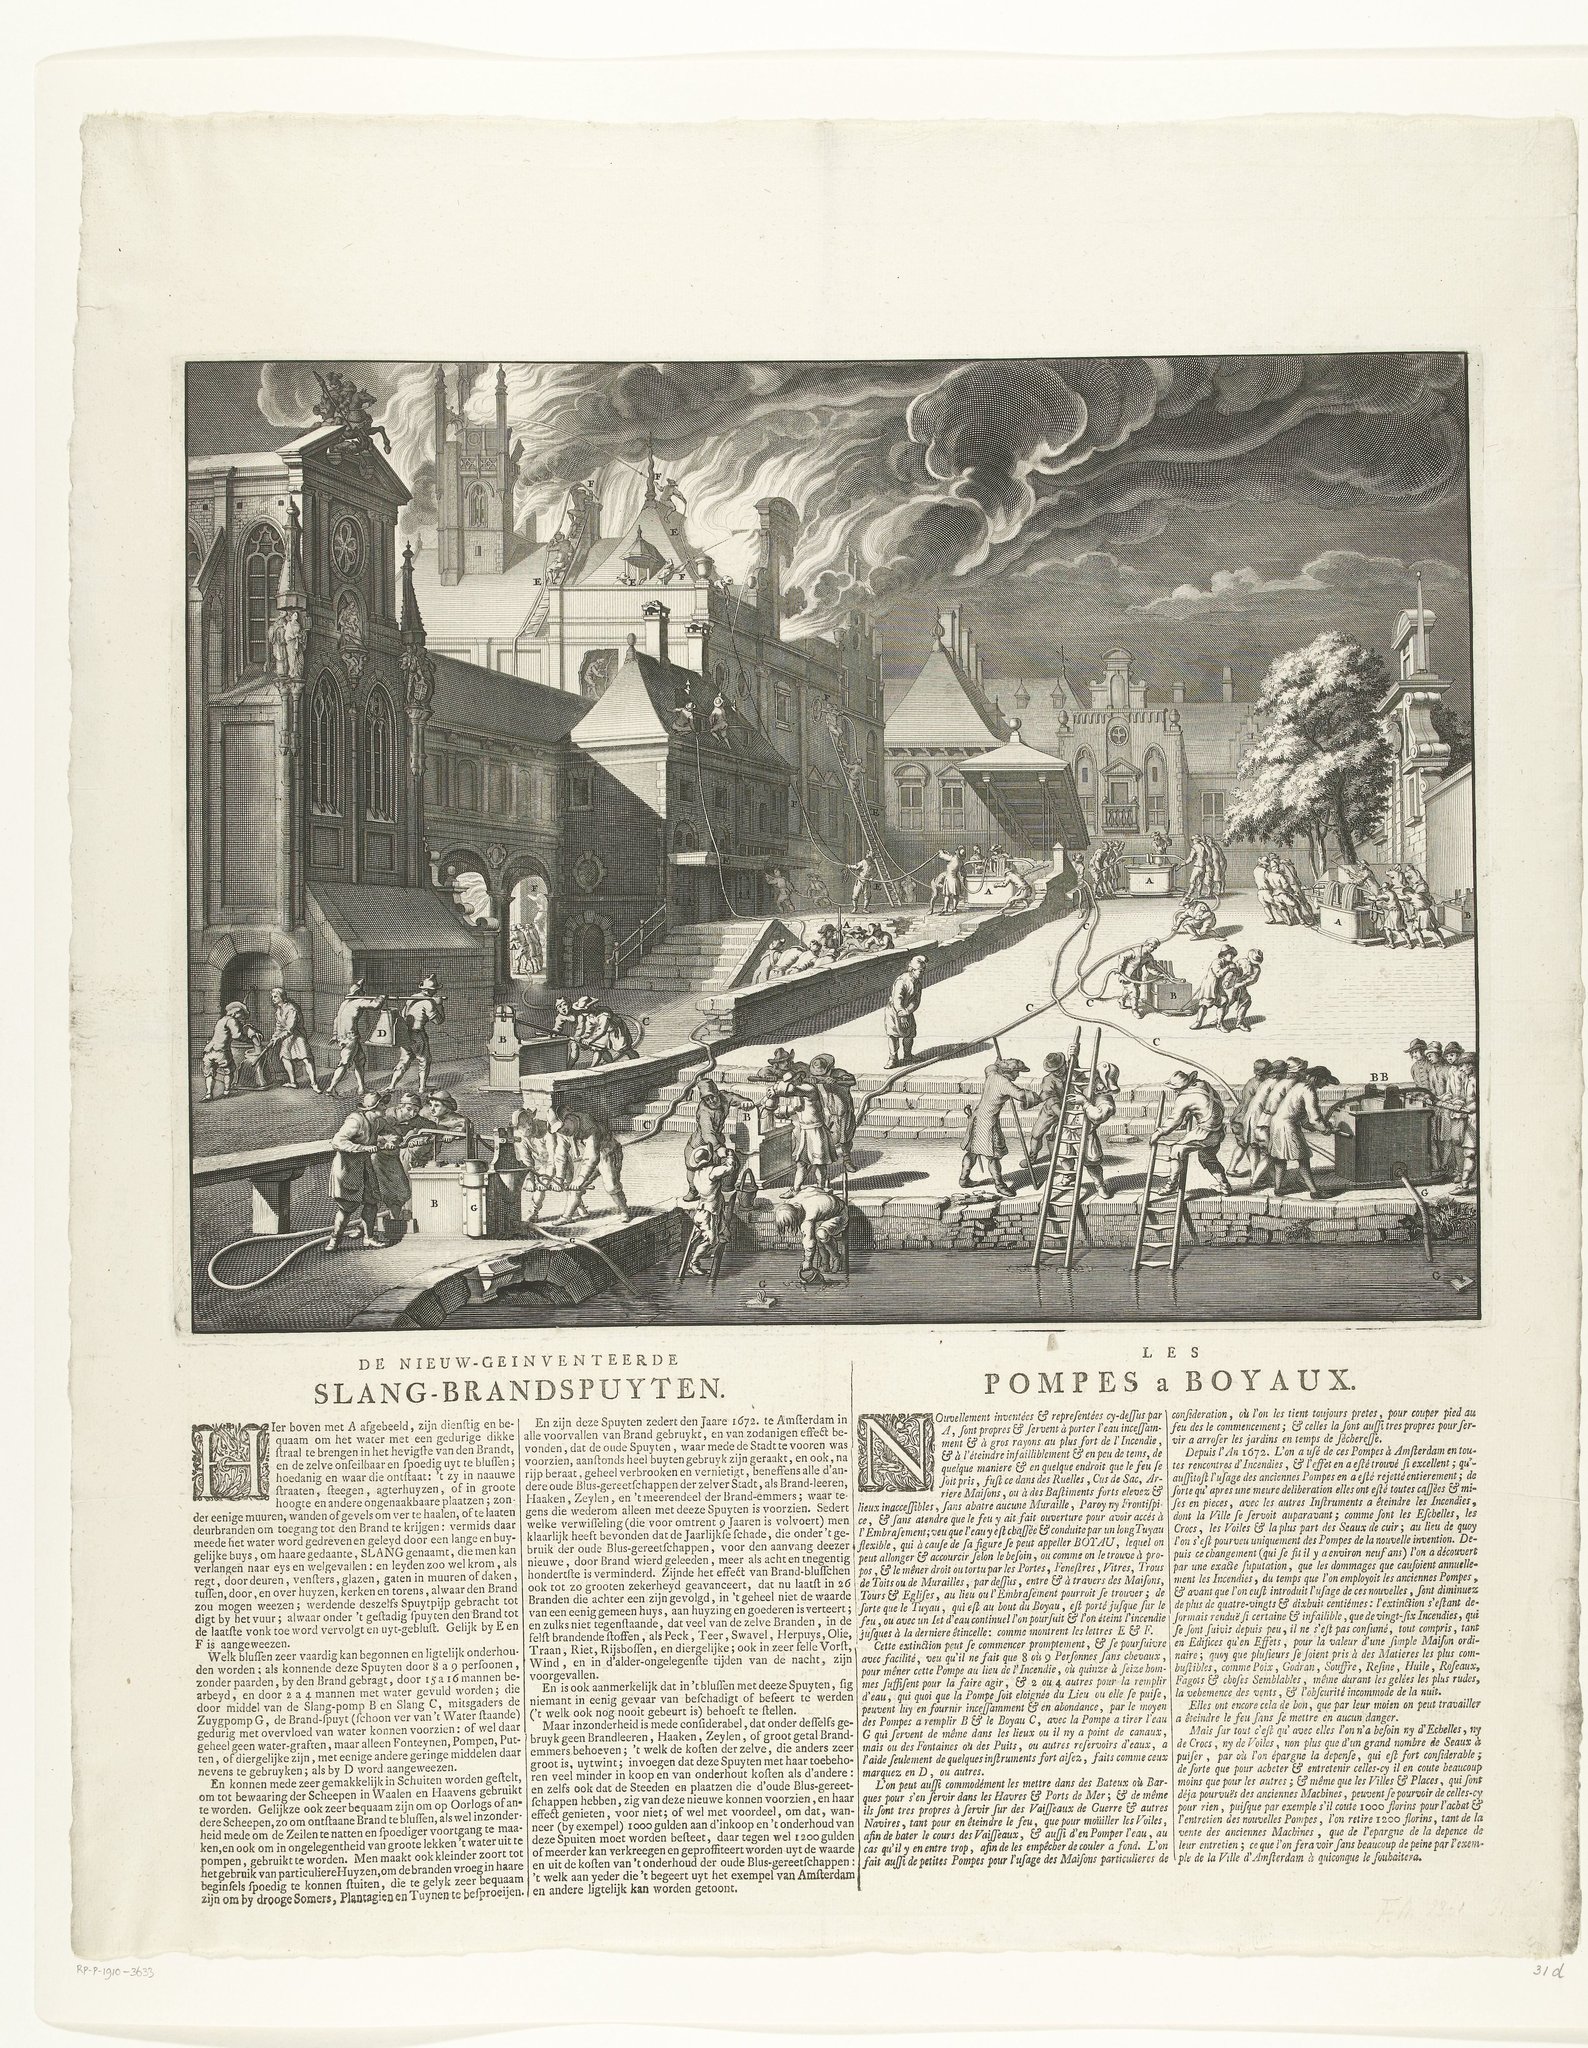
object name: print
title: Gebruik van de nieuwe brandspuitslangen, 1677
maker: joseph mulder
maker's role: print maker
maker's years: 1658-1718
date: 1677-1718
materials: paper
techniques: etching, letterpress printing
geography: northern netherlands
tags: painter, print maker, draughtsman, jan van der heyden, amsterdam, jan van der heyden (de jonge), fire-extinguishing equipment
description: Blad met een grote voorstelling van de toepassing van de nieuwe slangbrandspuiten van Jan van der Heyden en Jan van der Heyden de Jonge bij het blussen van een brand in een kerk of paleis een imaginaire stad. Rechtsvoor een pomp bediend door 8 man. Onderaan op het blad gedrukt staan de beschrijvingen in Nederlands en Frans. Behoort tot de bijprenten bij het Brandspuitenboek van Jan van der Heyden.